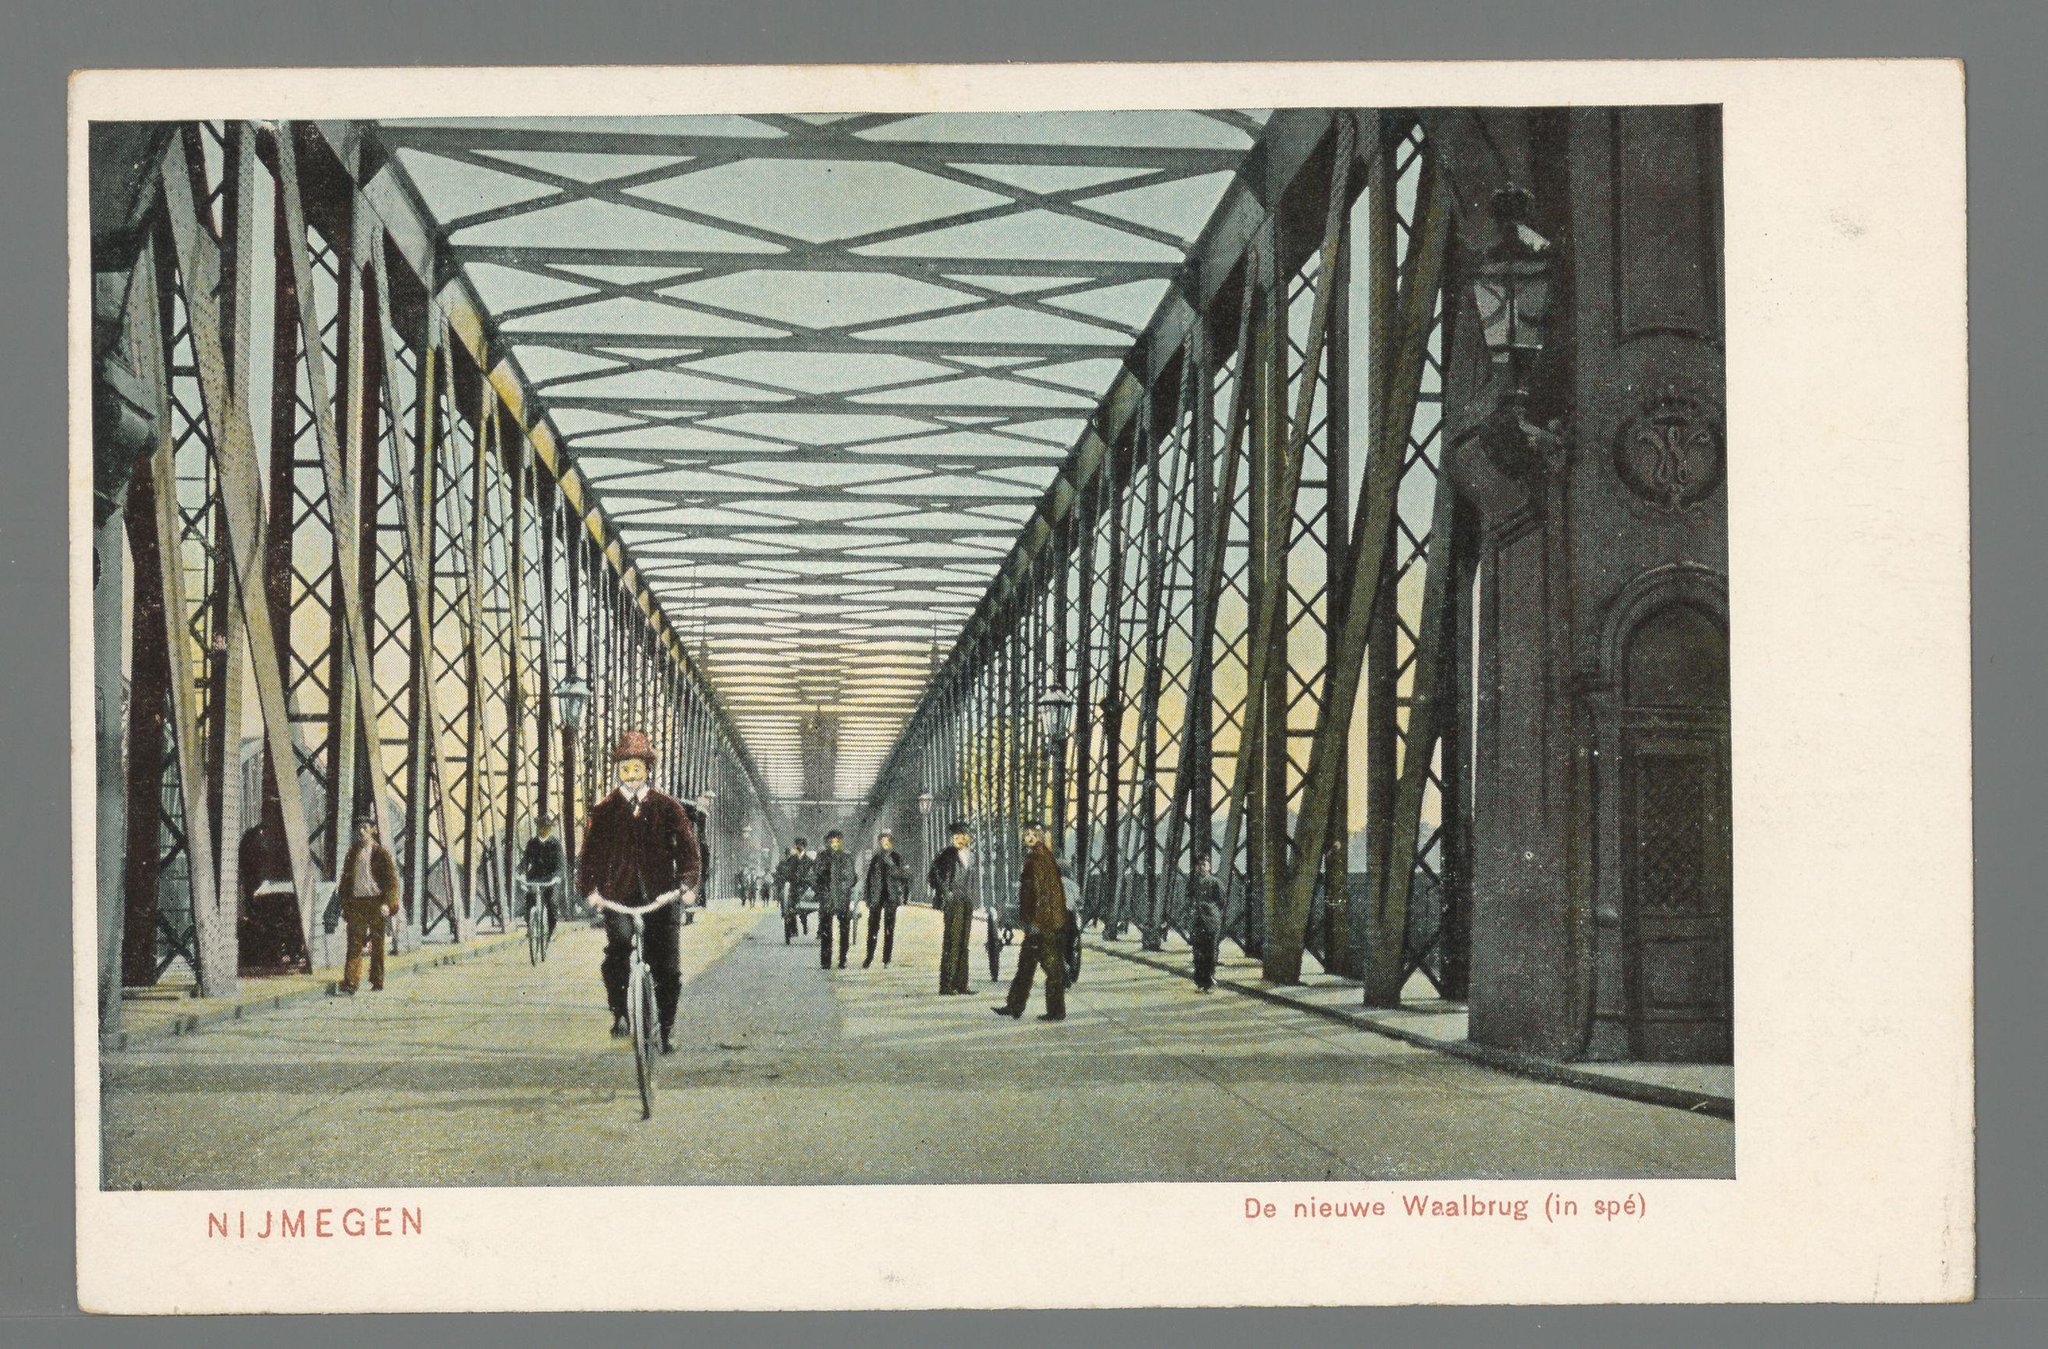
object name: ansichtkaart, prentbriefkaart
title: Nijmegen. De nieuwe Waalbrug (in spé)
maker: Anonymous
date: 1906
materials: cardboard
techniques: lithograph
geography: nijmegen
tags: river, bridge in city across river, canal, etc., nijmegen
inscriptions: date